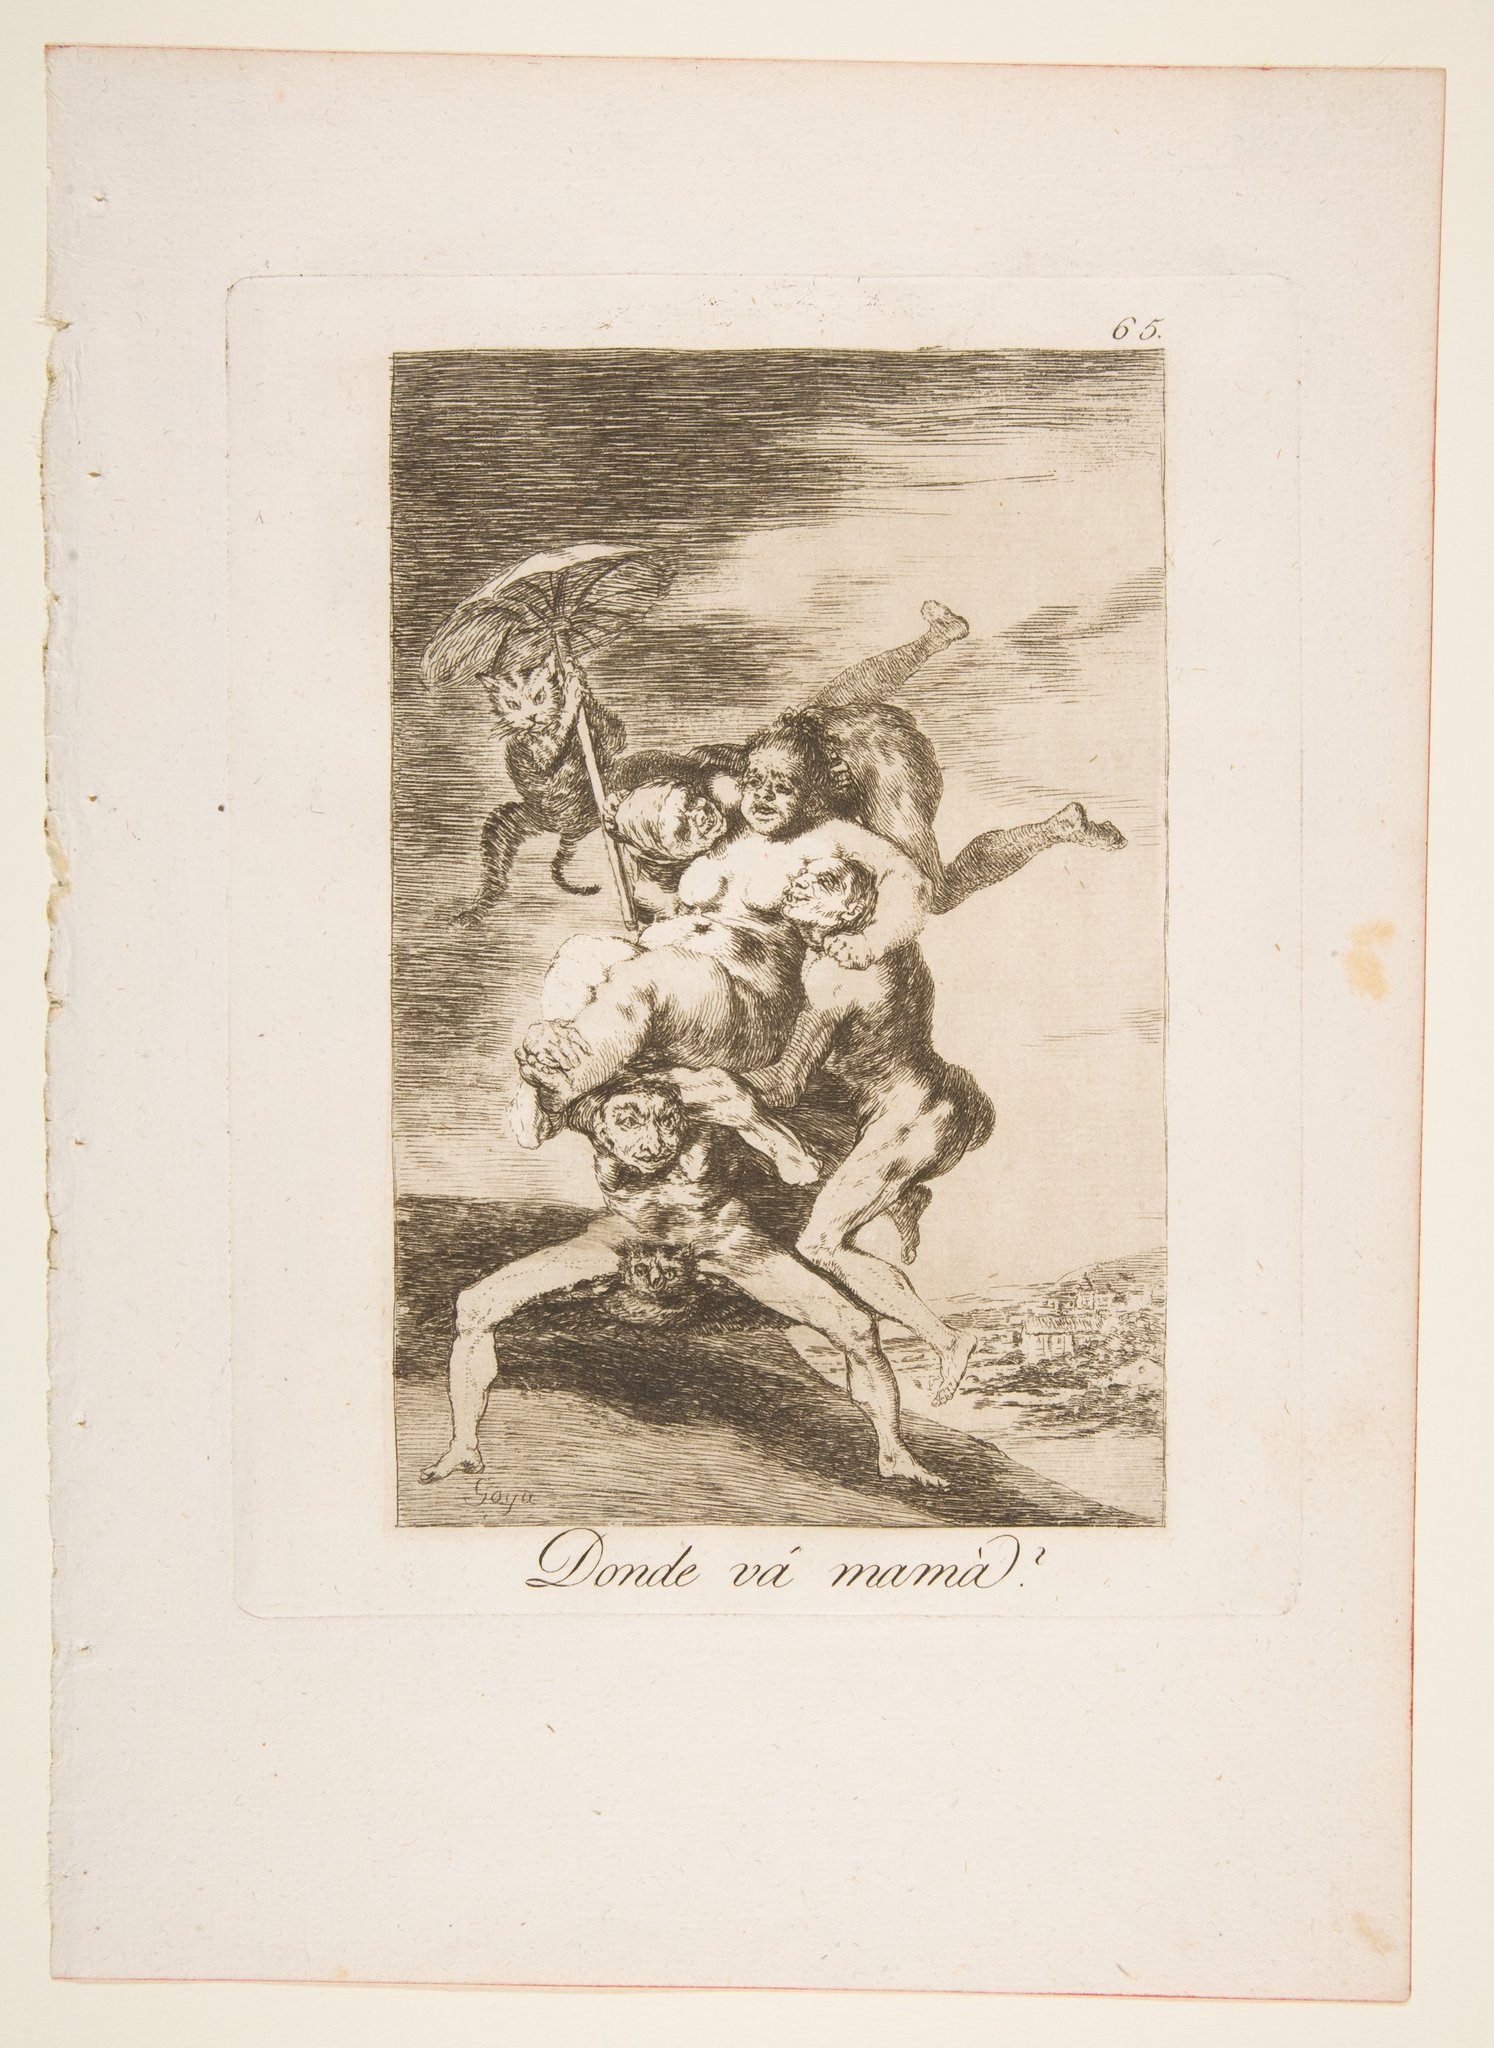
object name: print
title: Plate 65 from "Los Caprichos": Where is mom going? (Donde vá mamá?)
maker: goya (francisco de goya y lucientes)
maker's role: artist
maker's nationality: spanish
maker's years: 1746-1828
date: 1799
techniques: aquatint, drypoint, etching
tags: female nudes,cats